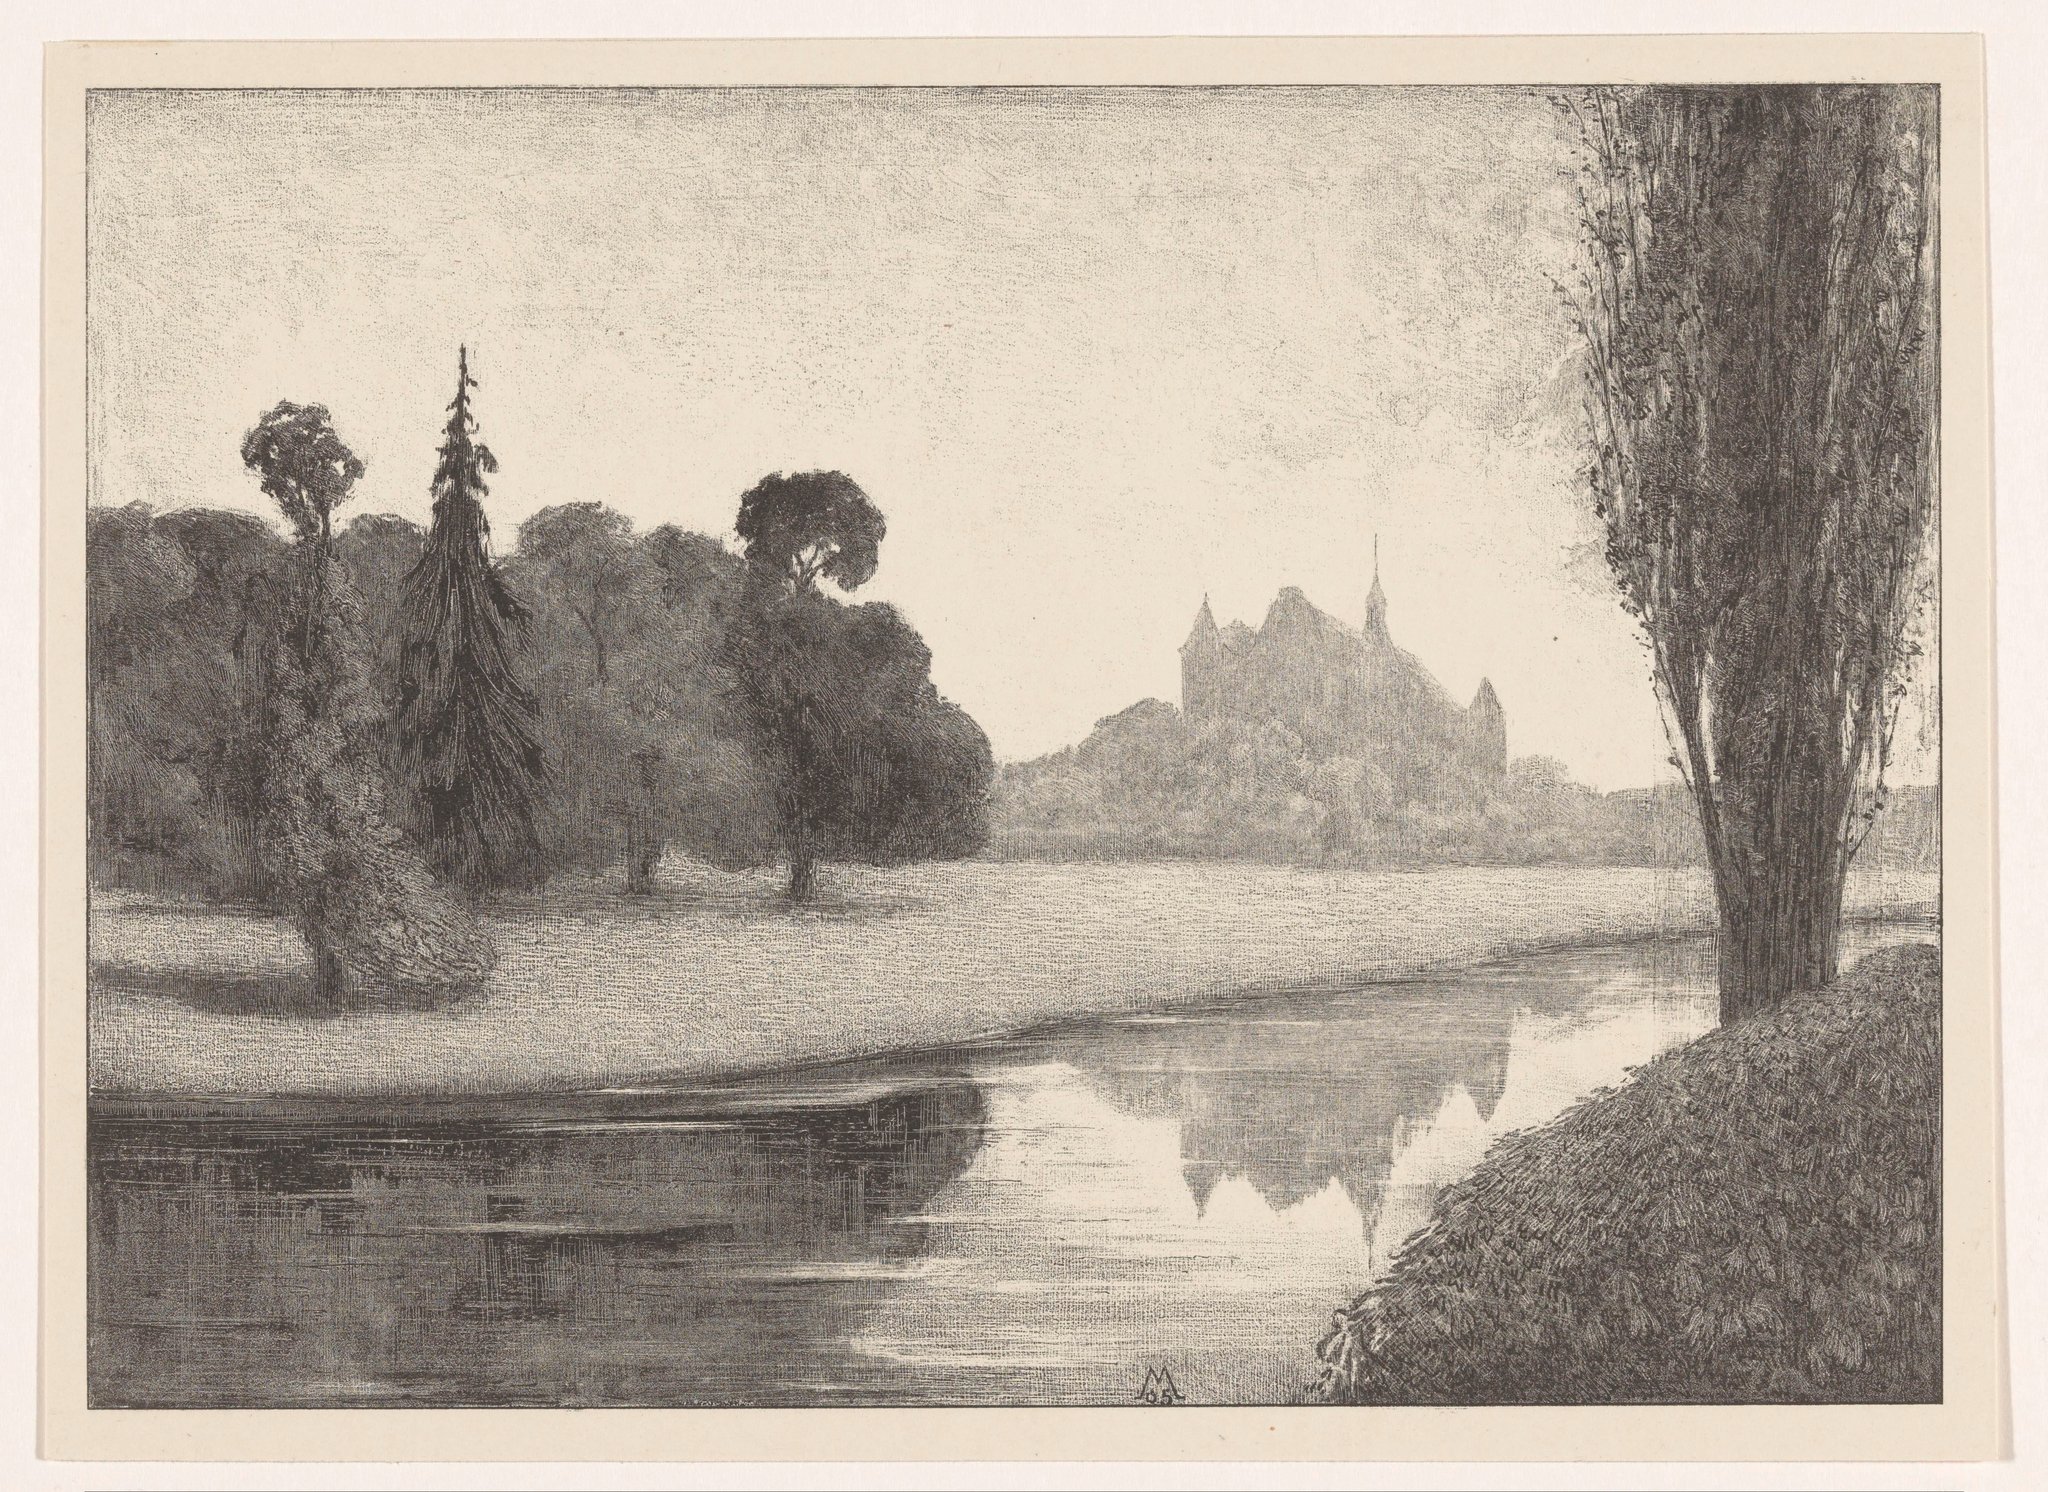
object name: print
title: Park bij kasteel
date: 1905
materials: paper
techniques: lithograph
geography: amsterdam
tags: park, castle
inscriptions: collector's mark: Lugt 2228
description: Een park met bomen en water. Aan de horizon het silhouet van een kasteel.